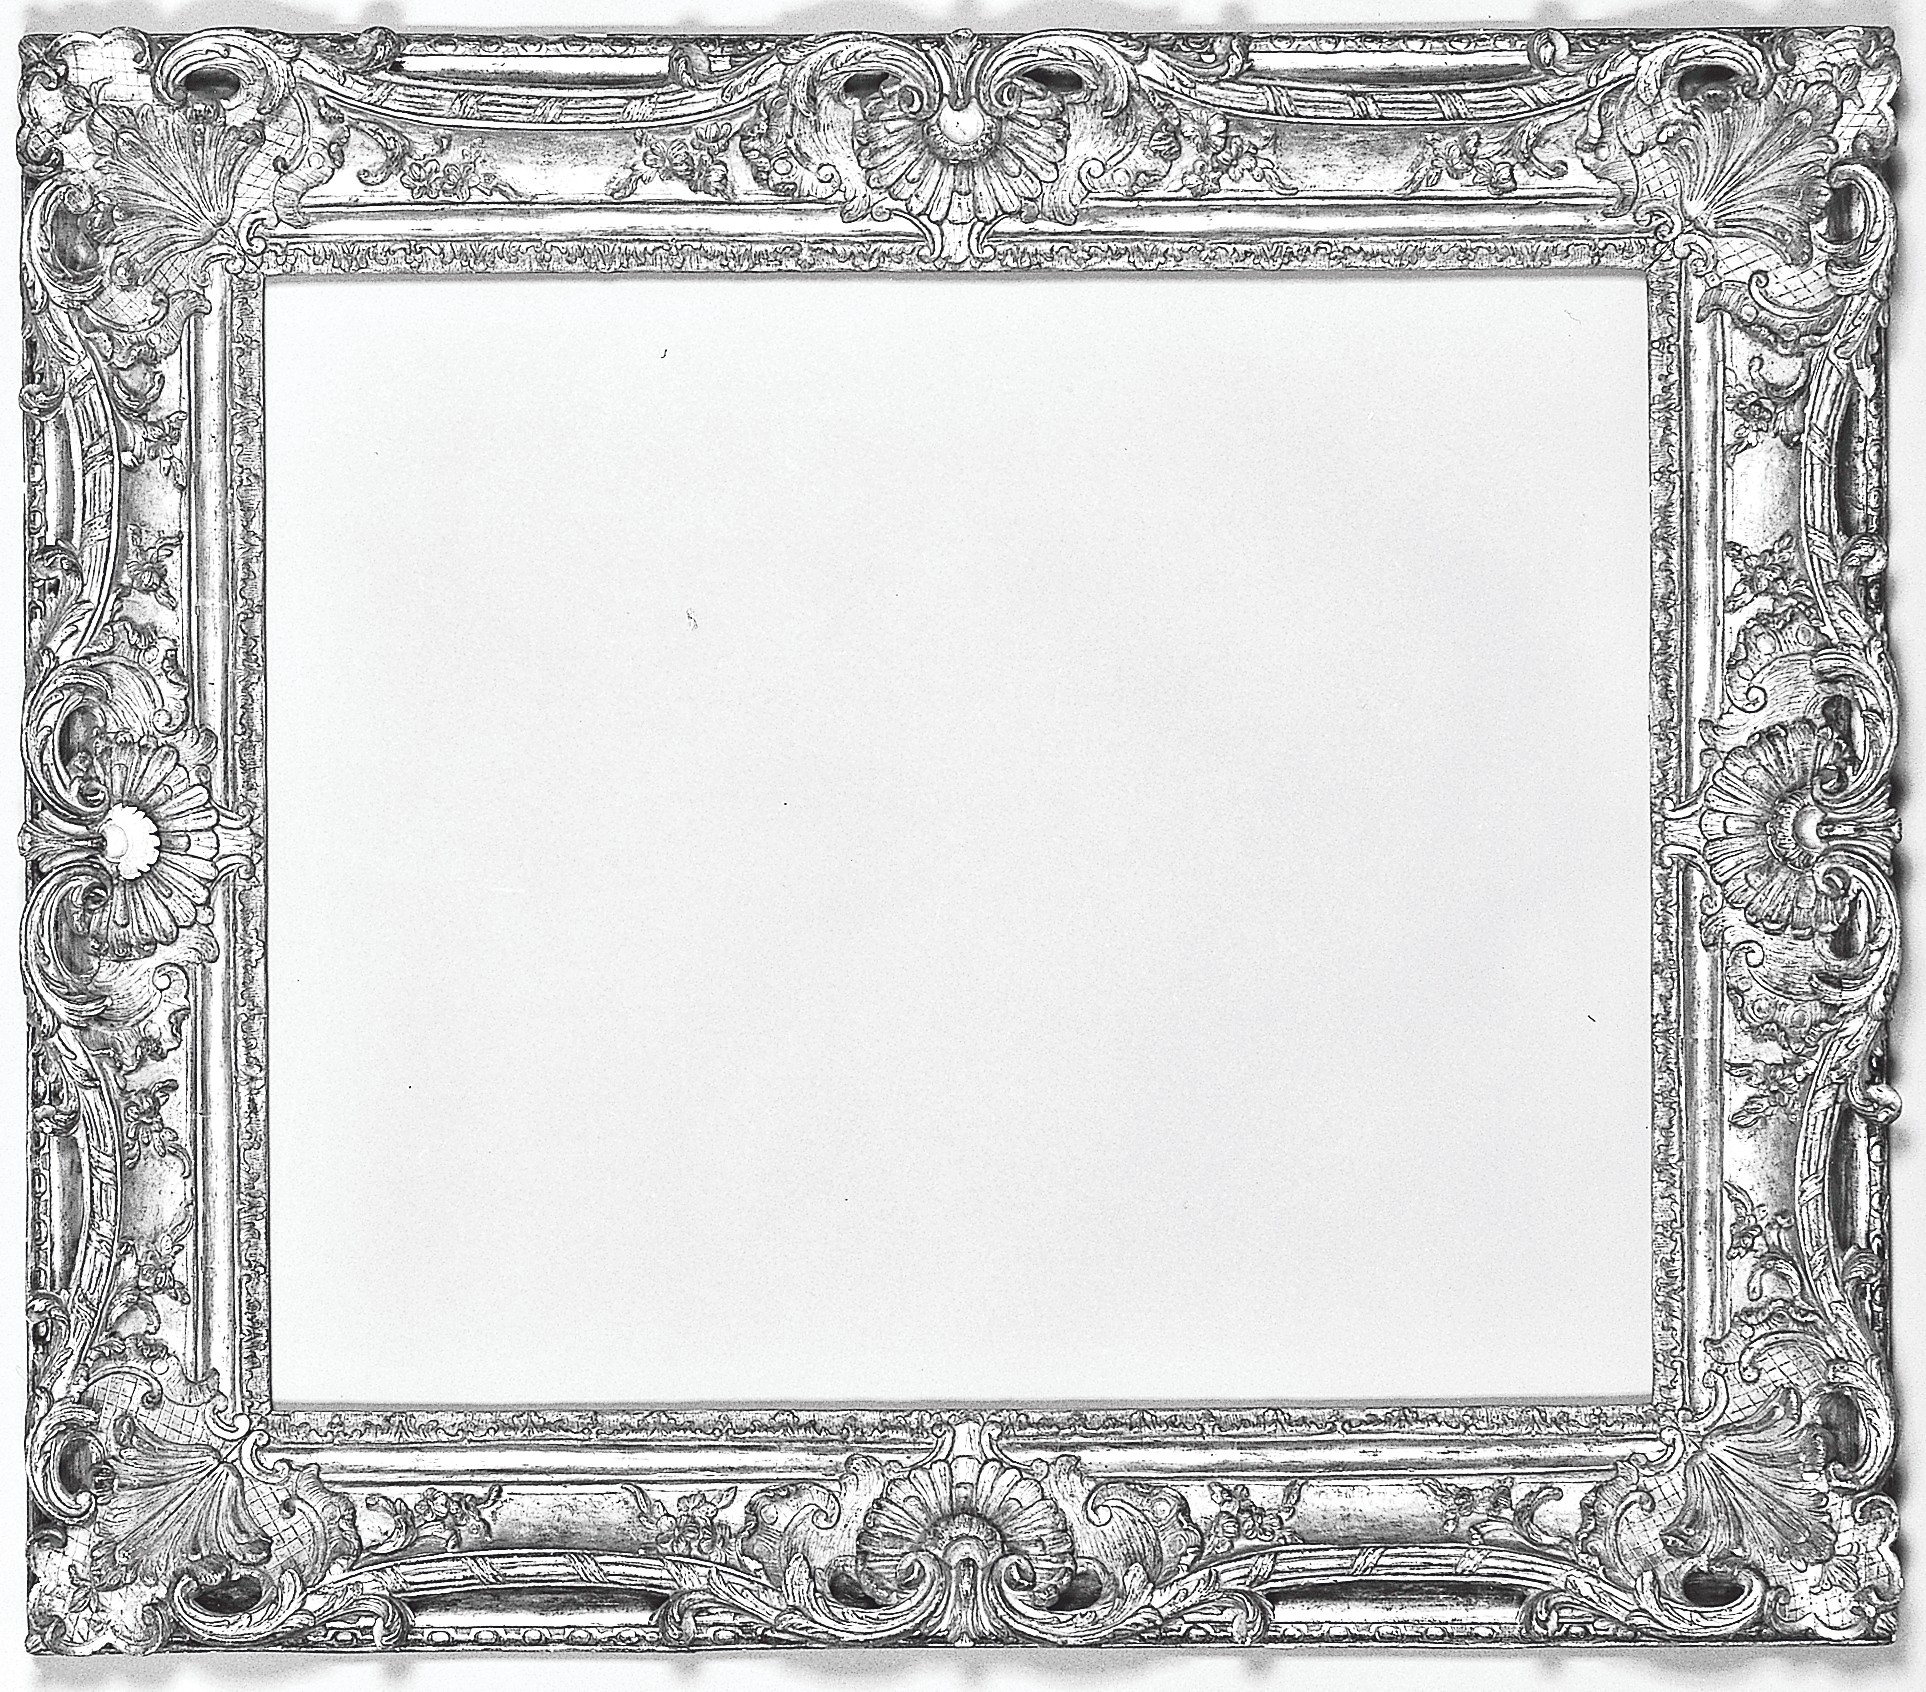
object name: frame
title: Swept frame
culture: french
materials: feather, wood